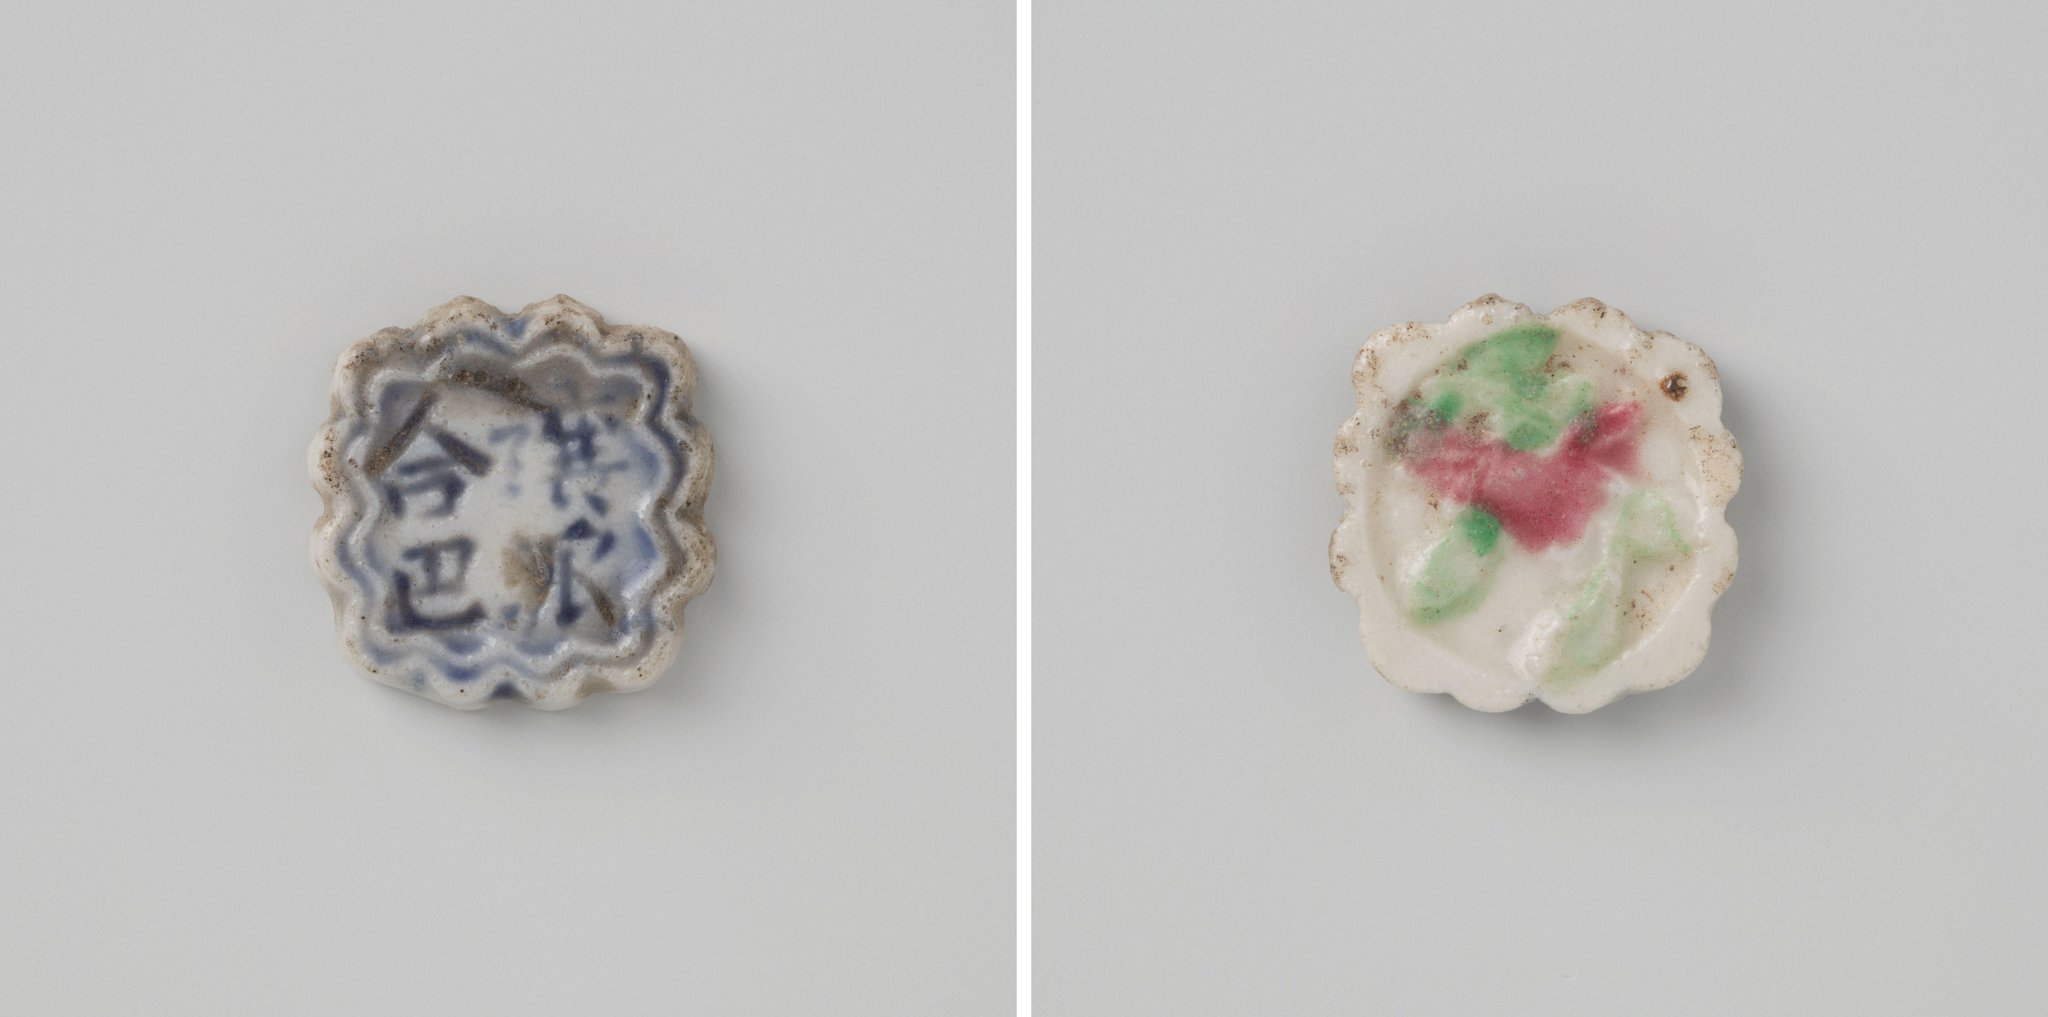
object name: coin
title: Thailand, speelhuispenning uitThailand, 1760-1871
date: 1760-1871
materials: porcelain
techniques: firing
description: Vierkanten, gekartelde porseleinen speelhuispenning, die ook als munt is gebruikt. Voorzijde: vier Chinese karakters. Keerzijde: afbeelding.